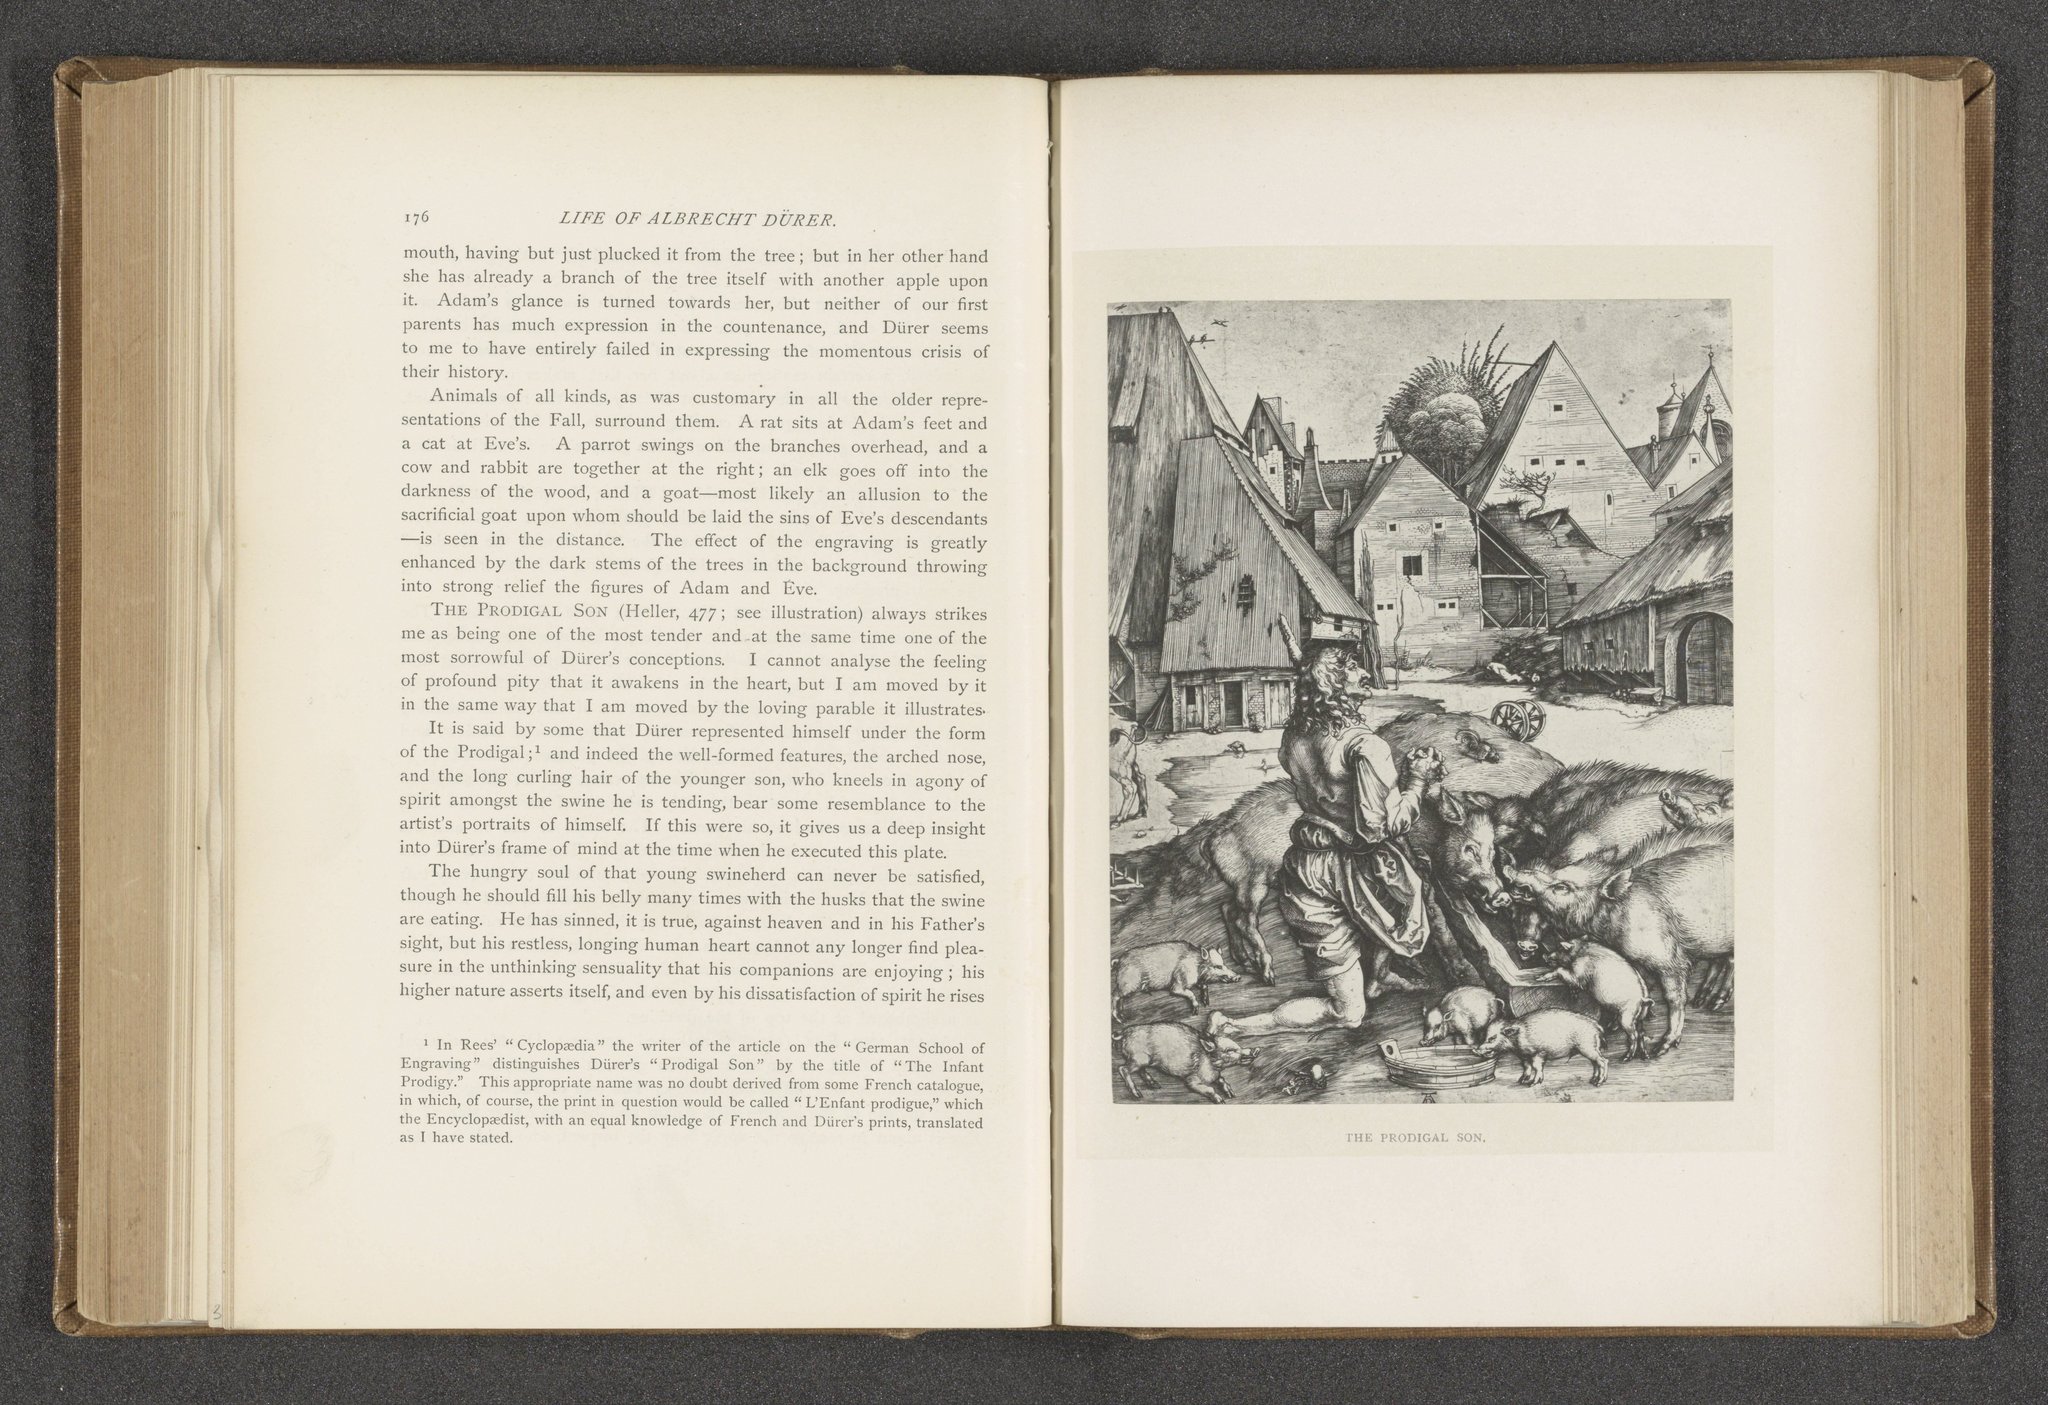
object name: page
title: The Prodigal Son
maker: Anonymous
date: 1860-1870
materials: photographic support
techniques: carbon print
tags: print, e.g.: engraving, etching, lithograph, the prodigal son tends the swine and eats from their trough